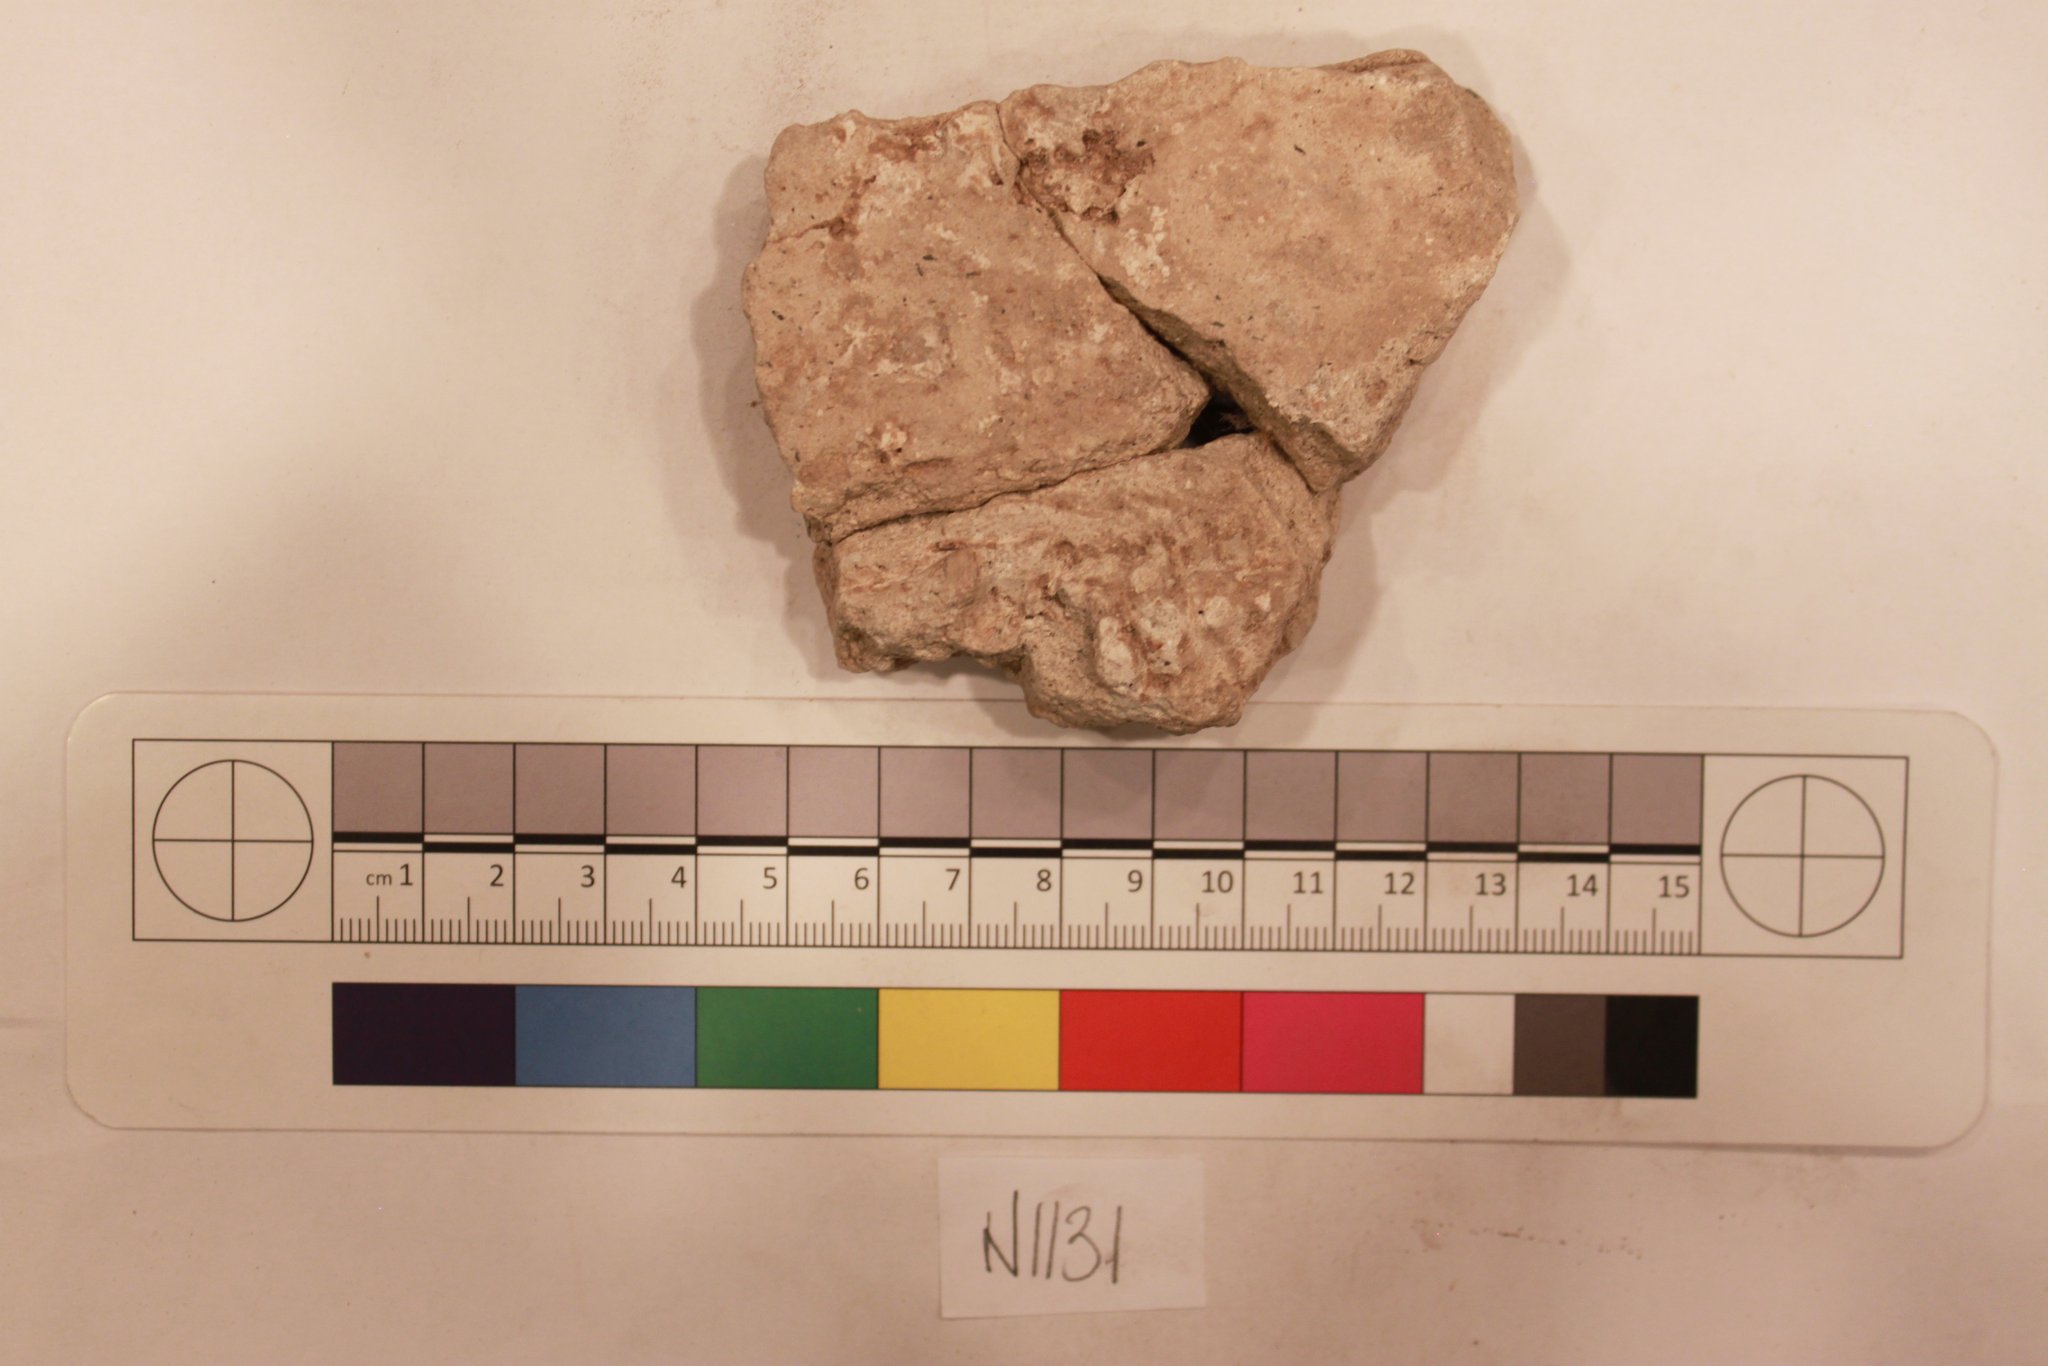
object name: fragment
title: Stucco Fragment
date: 701-1200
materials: plaster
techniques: carving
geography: iran